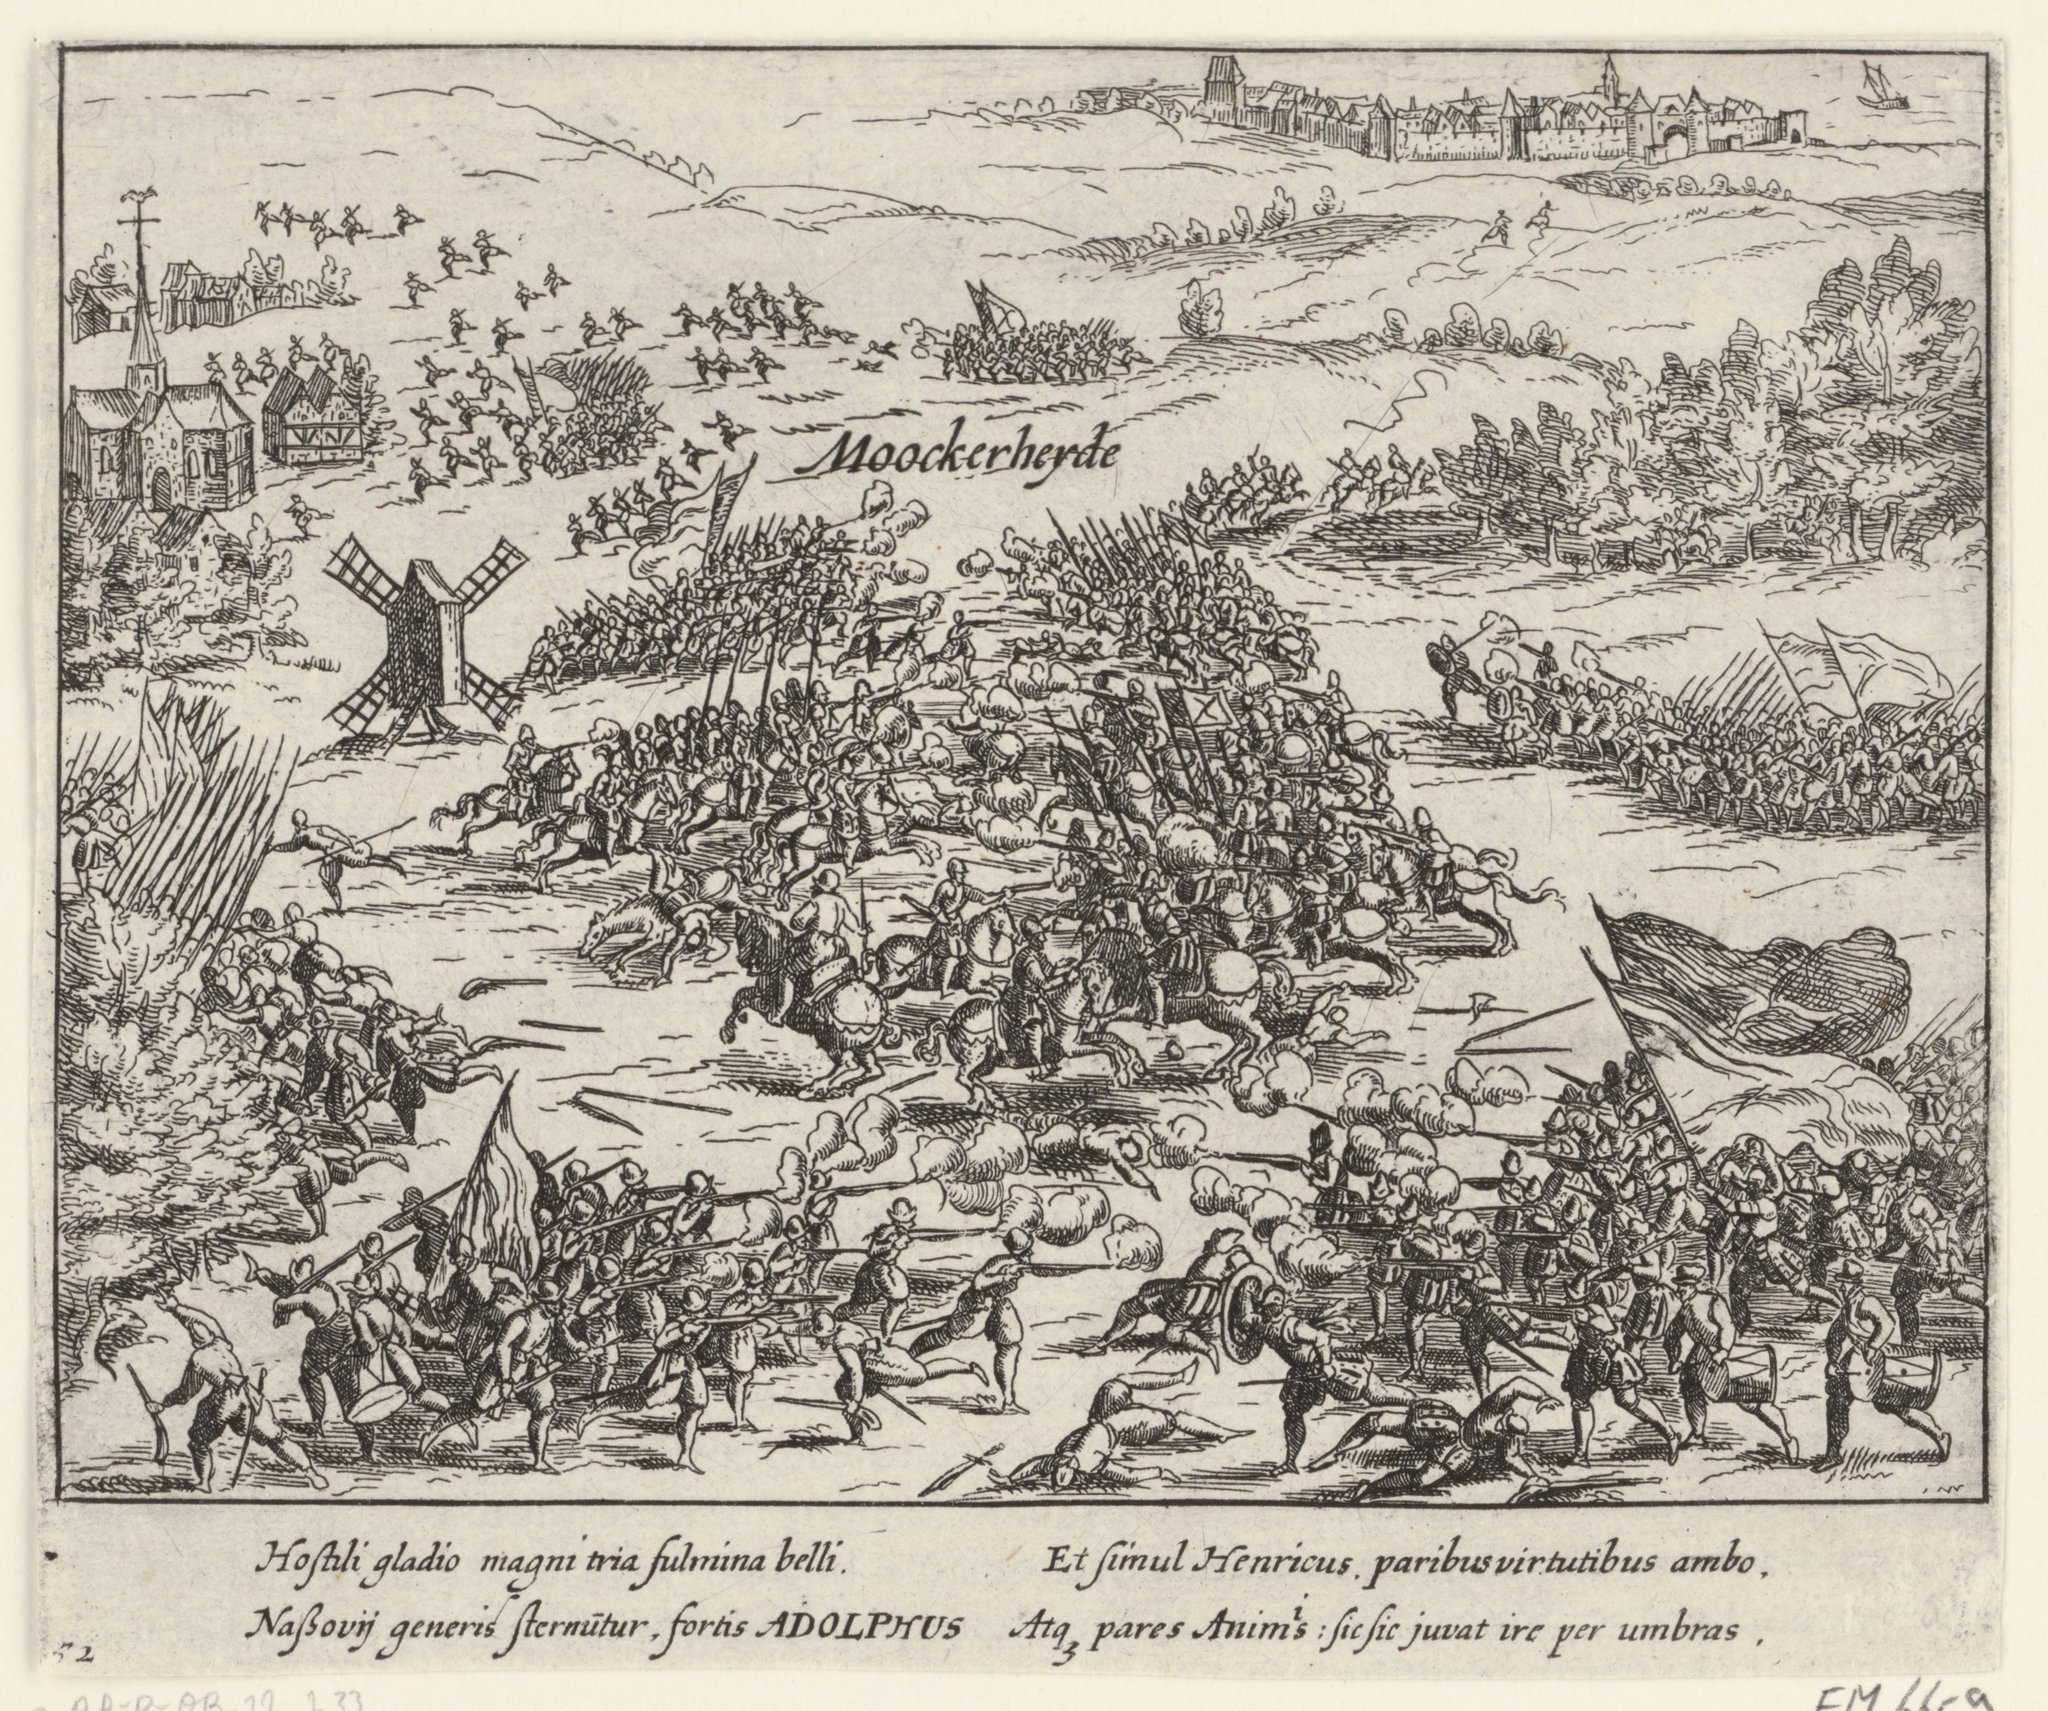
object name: print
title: Slag op de Mookerheide, 1574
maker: Anonymous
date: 1613-1615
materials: paper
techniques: etching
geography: northern netherlands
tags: battle (+ land forces), nijmegen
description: Slag op de Mookerheide, 14 april 1574. Veldslag tussen het leger van de opstandelingen onder bevel van Lodewijk en Hendrik van Nassau en het Spaanse leger onder de veldheren d'Avila, Mendoza en Mondragon. Linksboven Nijmegen, rechts Mook. Met onderschrift van 4 regels in het Latijn. Genummerd: 52. Bedrukt op achterzijde met tekst in het Latijn.